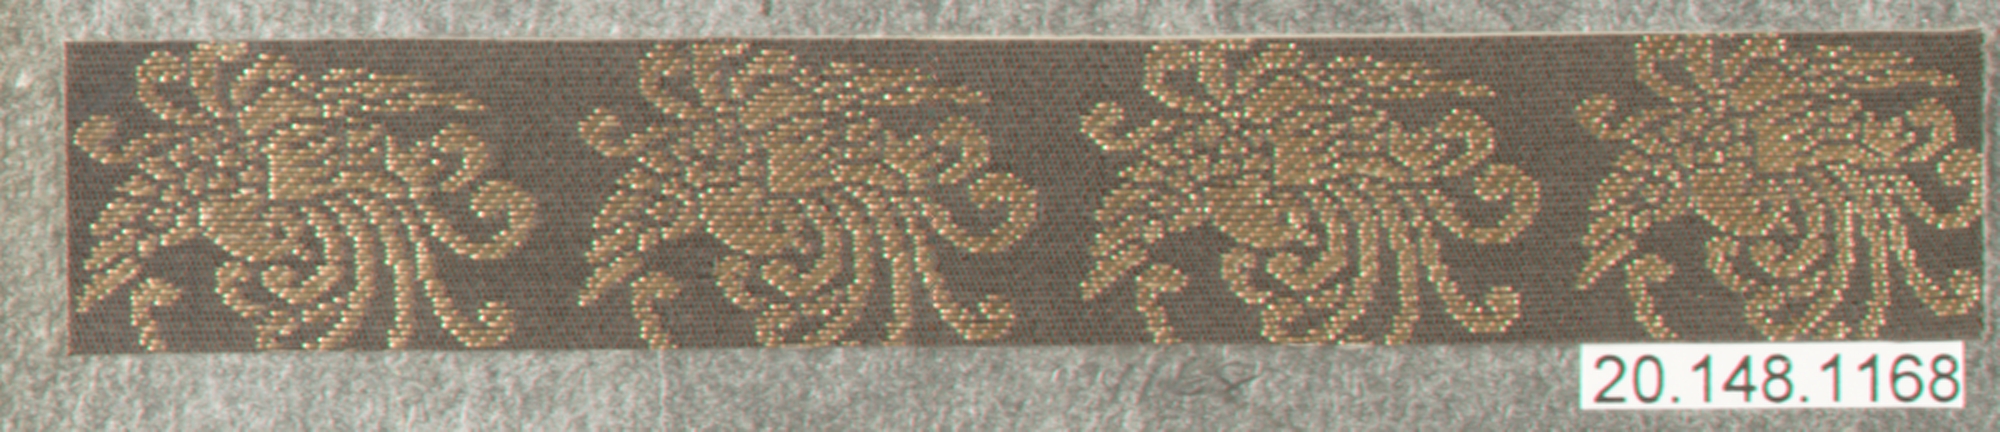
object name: piece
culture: japanese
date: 1801-1900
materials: silk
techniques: compound weave